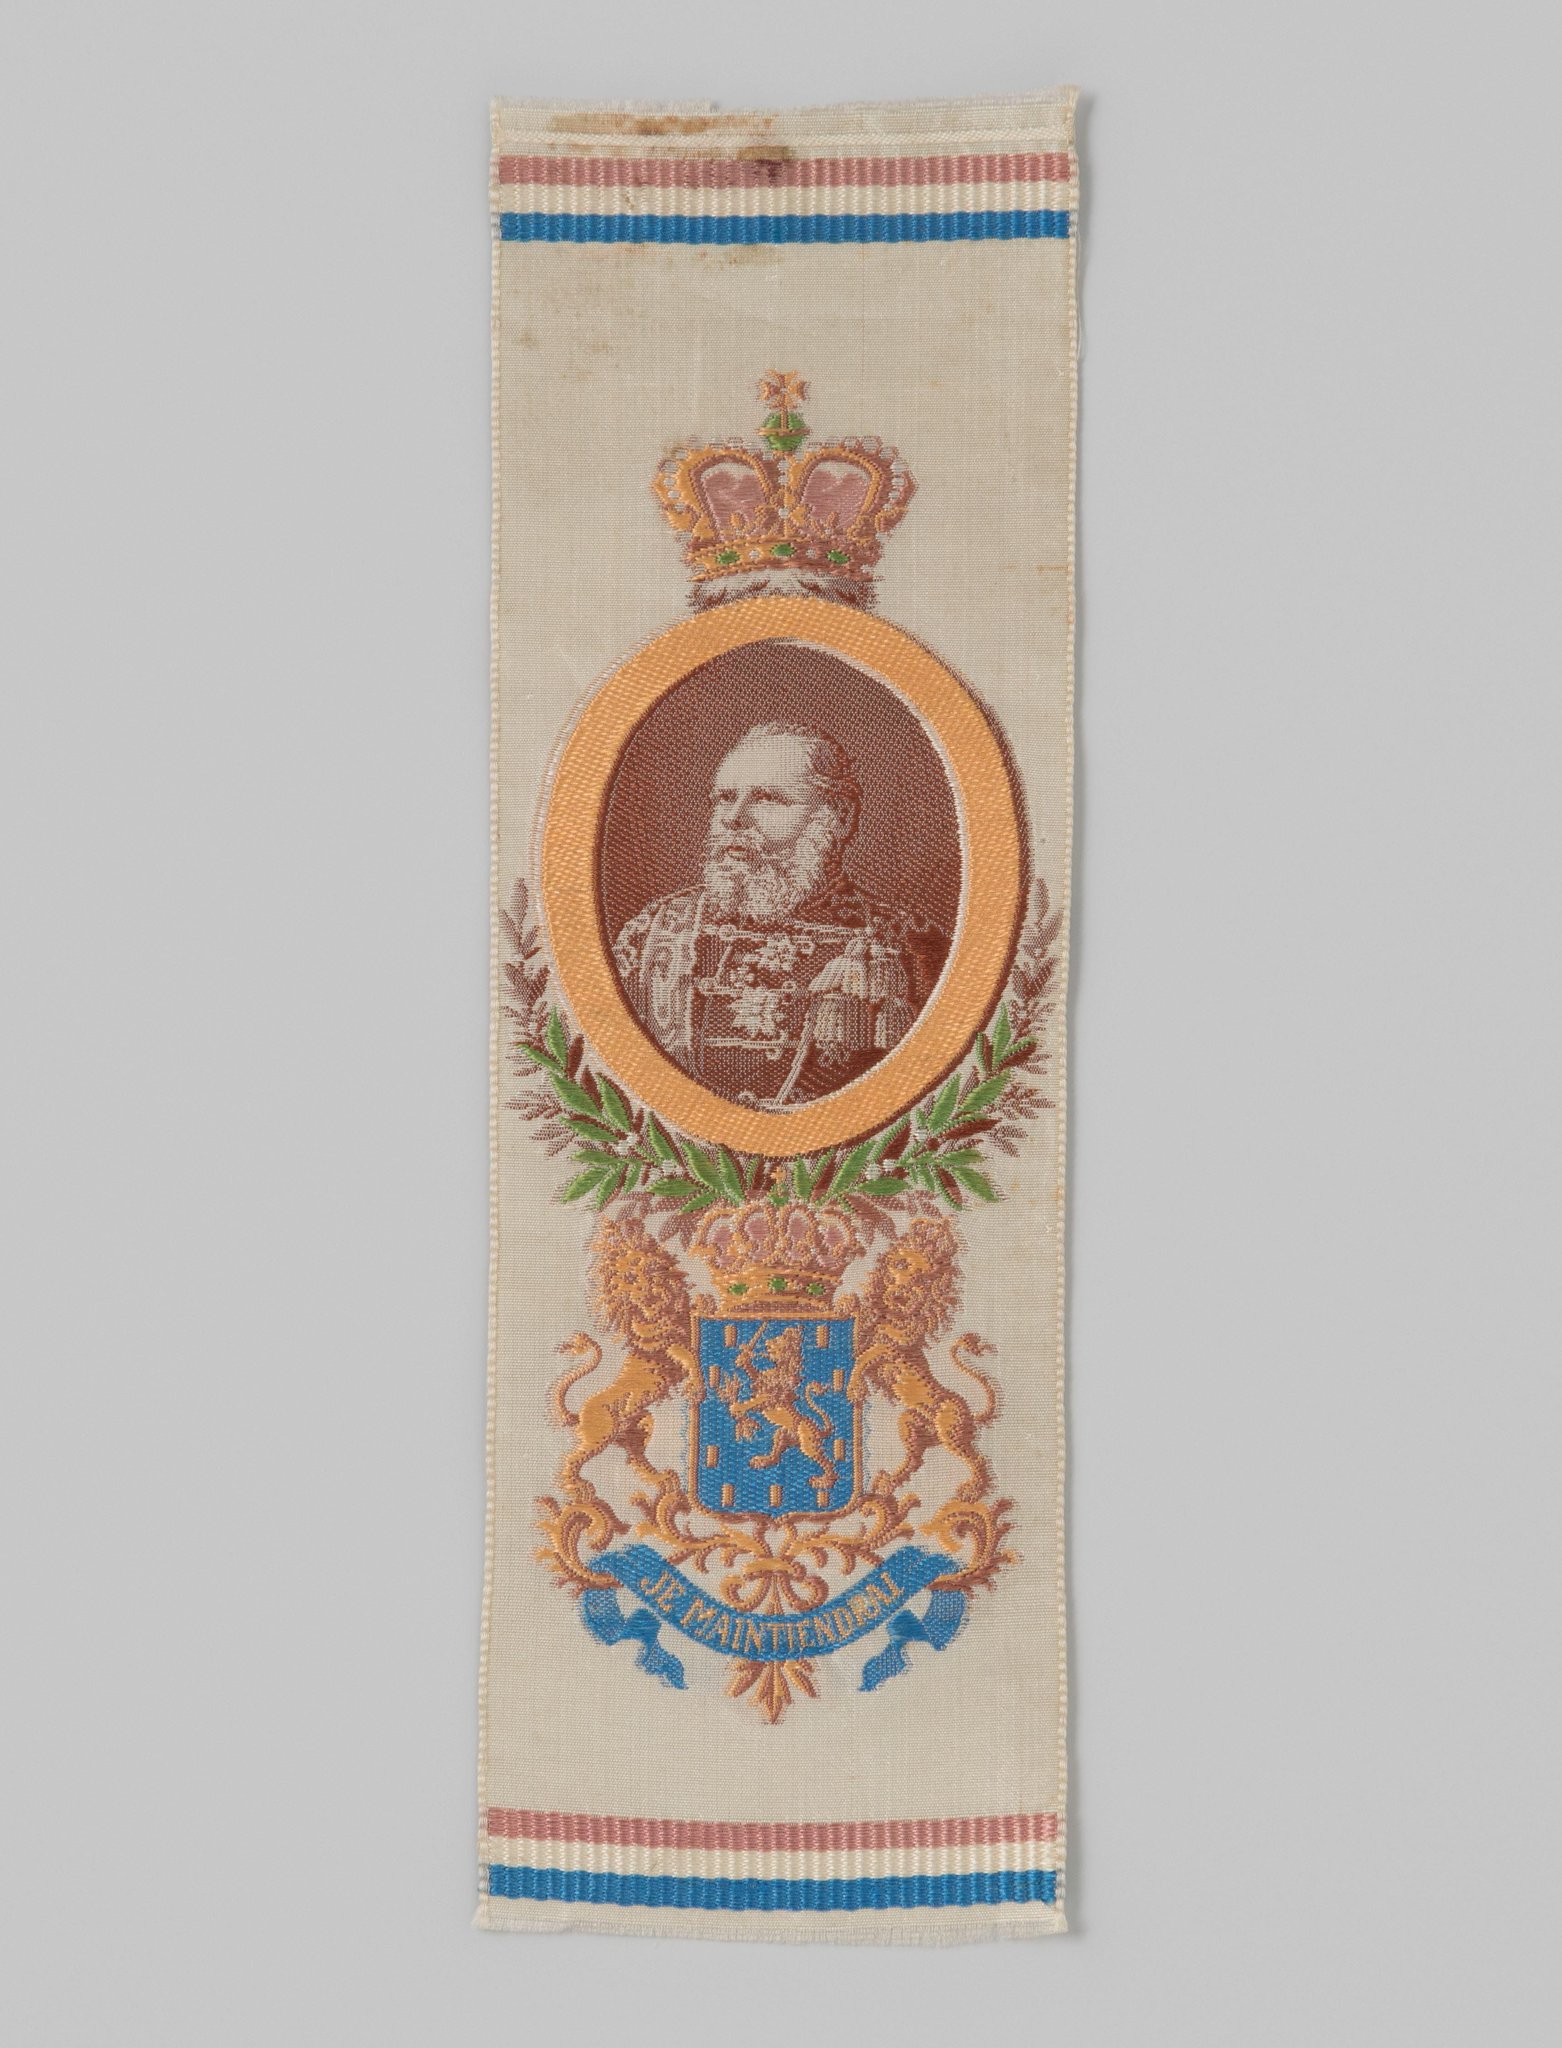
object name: ribbon material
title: Lint van witte zijde, versierd met het gekroonde medaillonportret van Koning Willem III uitgevoerd in brocheerwerk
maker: Anonymous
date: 1849-1890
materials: silk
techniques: brocade, weave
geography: netherlands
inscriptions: inscription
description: Lint van witte zijde, veriserd met brocheerwerk. Op het lint, dat langs de boven en onderrand is versierd met de driekleur, is het gekroonde medaillonportret van Koning Willem III aangebracht, waaronder het Nederlandse Rijkswapen.